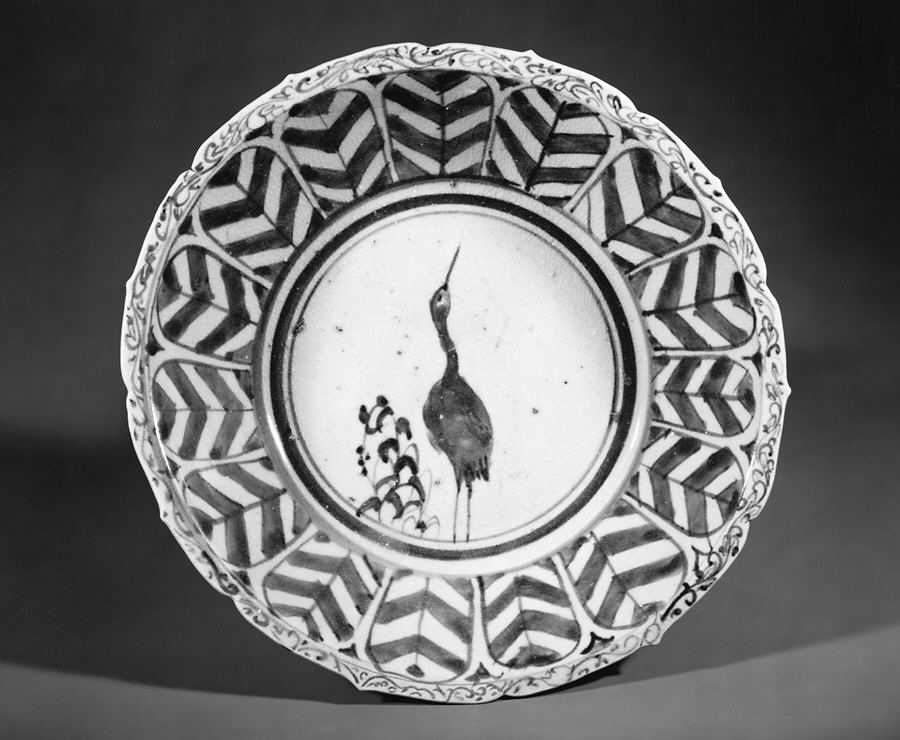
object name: dish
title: Deep Dish with Egret Design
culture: japanese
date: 1615-1868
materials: porcelain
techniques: underglaze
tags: birds